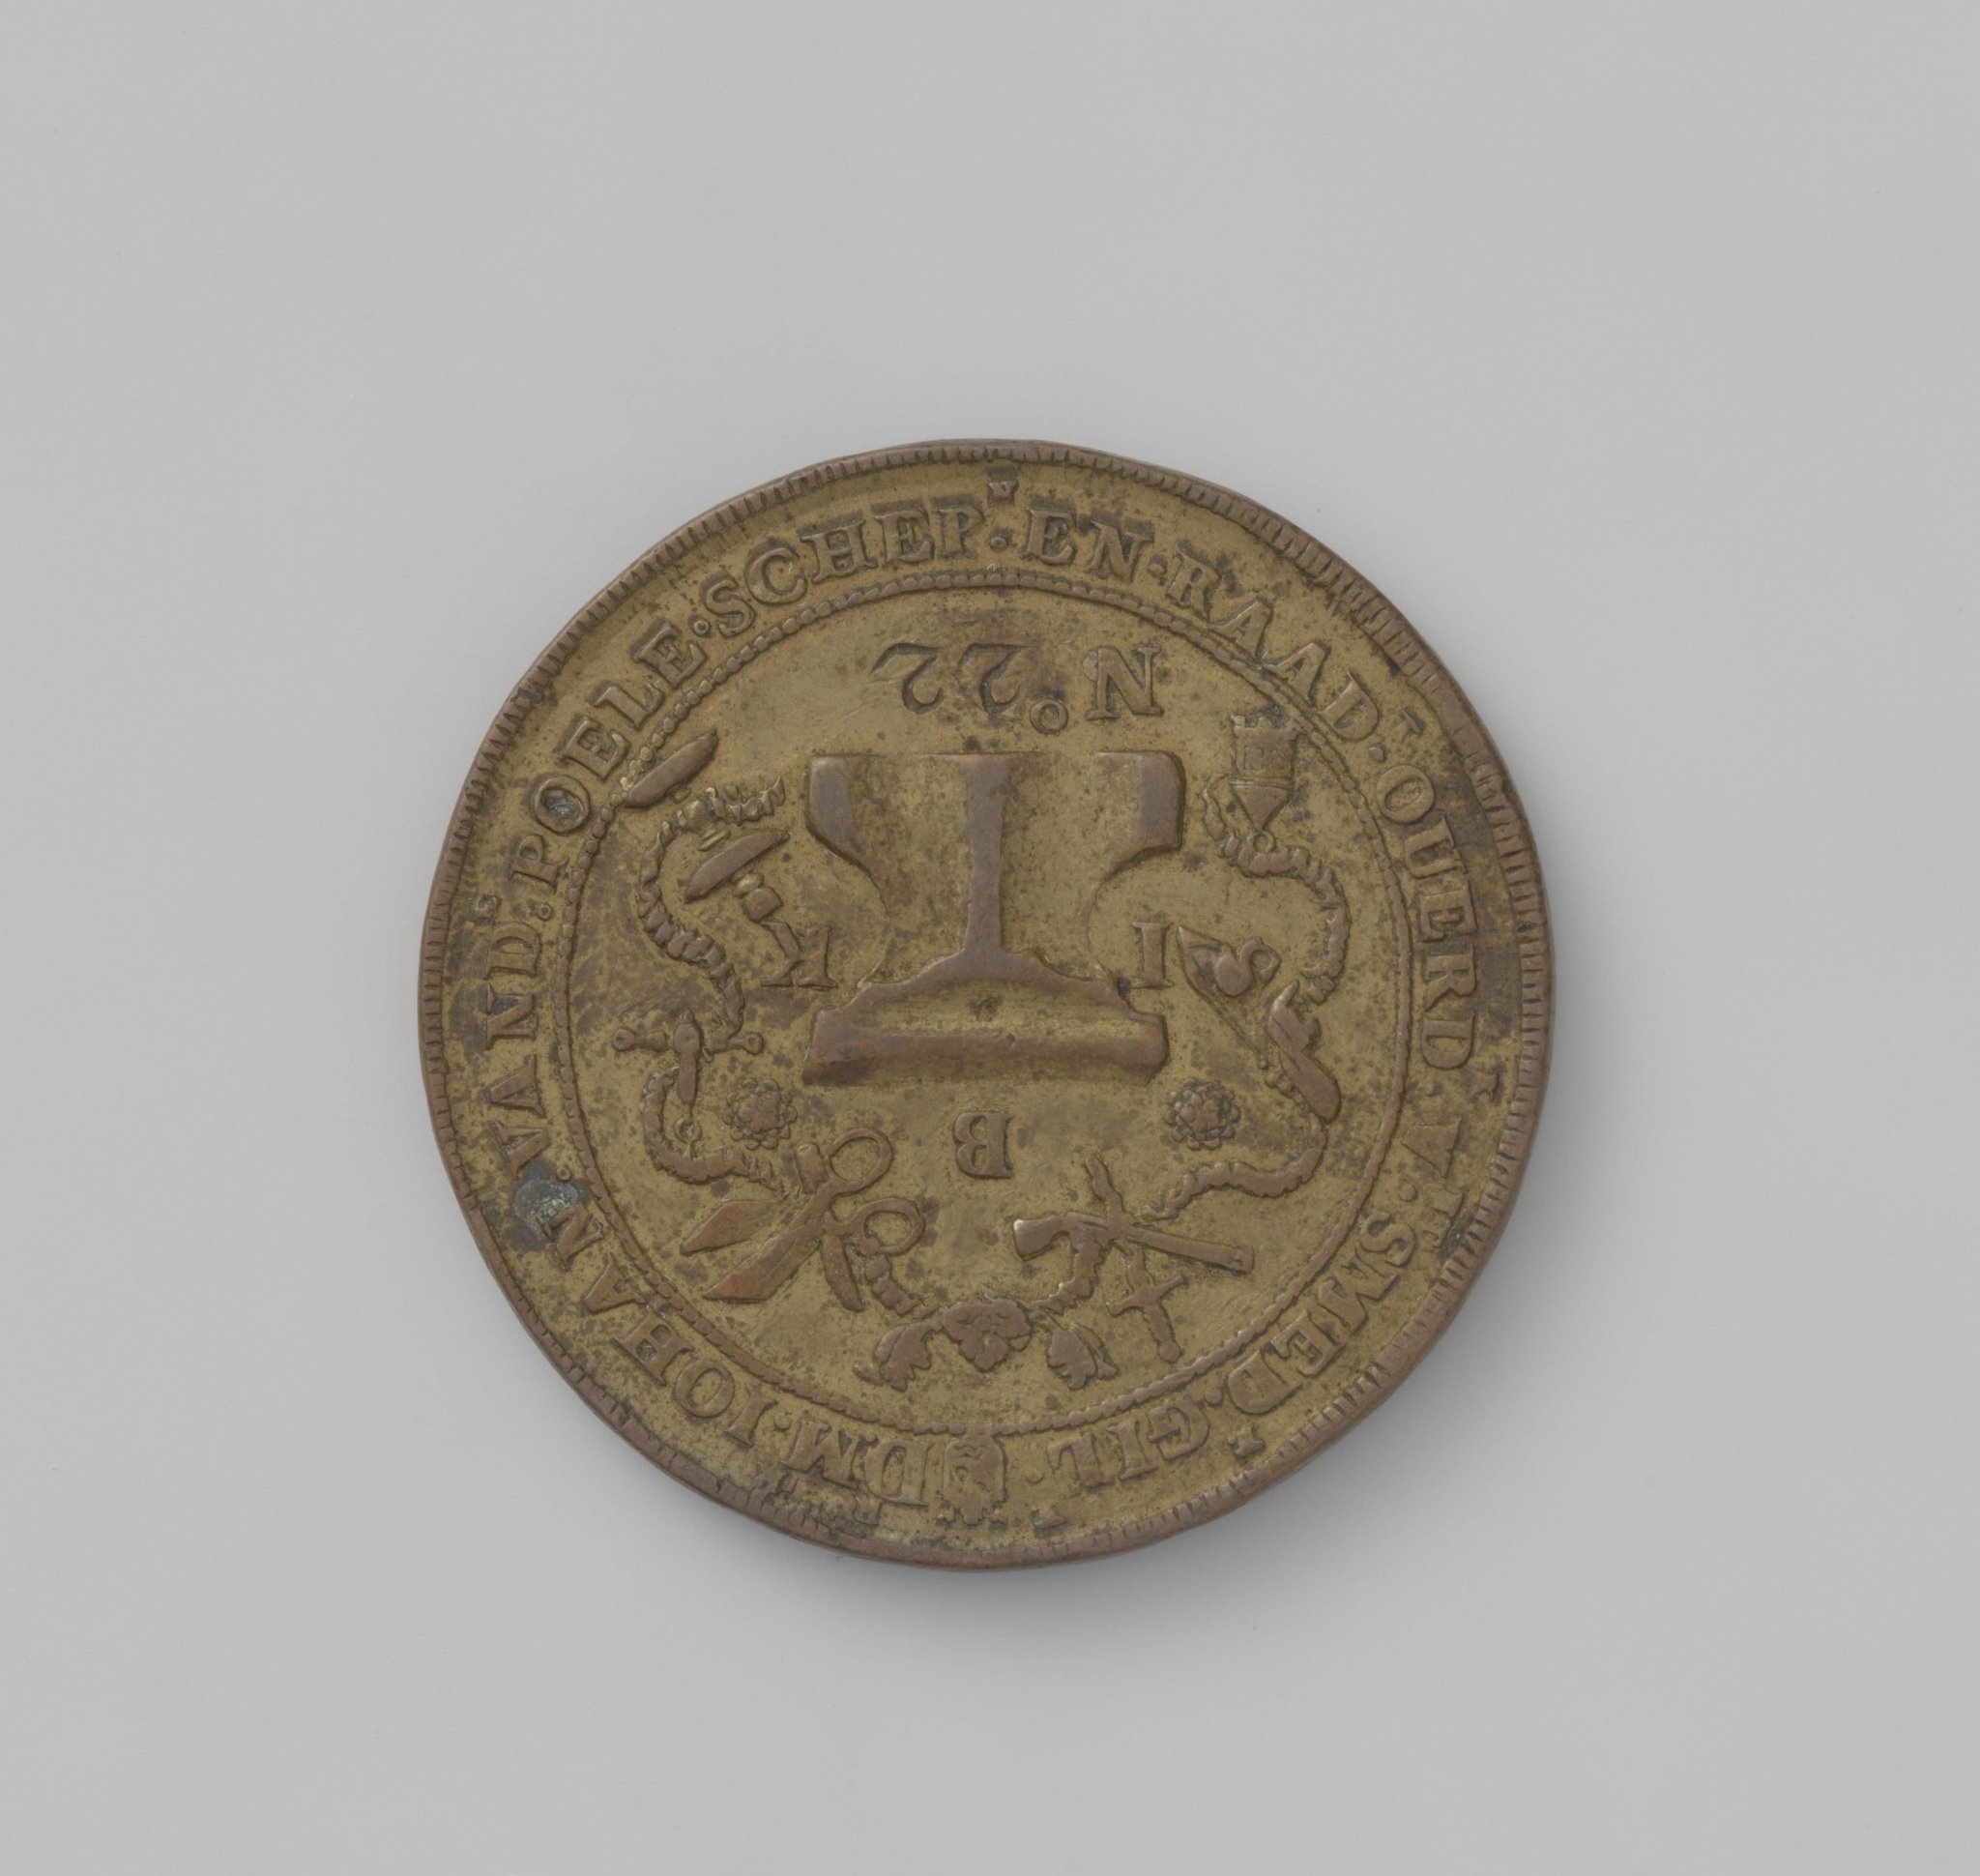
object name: medal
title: Smith’s medal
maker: willem du pre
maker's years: 1687-1722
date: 1690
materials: brass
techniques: engraving, striking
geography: middelburg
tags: middelburg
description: Guild medals Members of trade guilds had to identify themselves with a medal at their meetings.